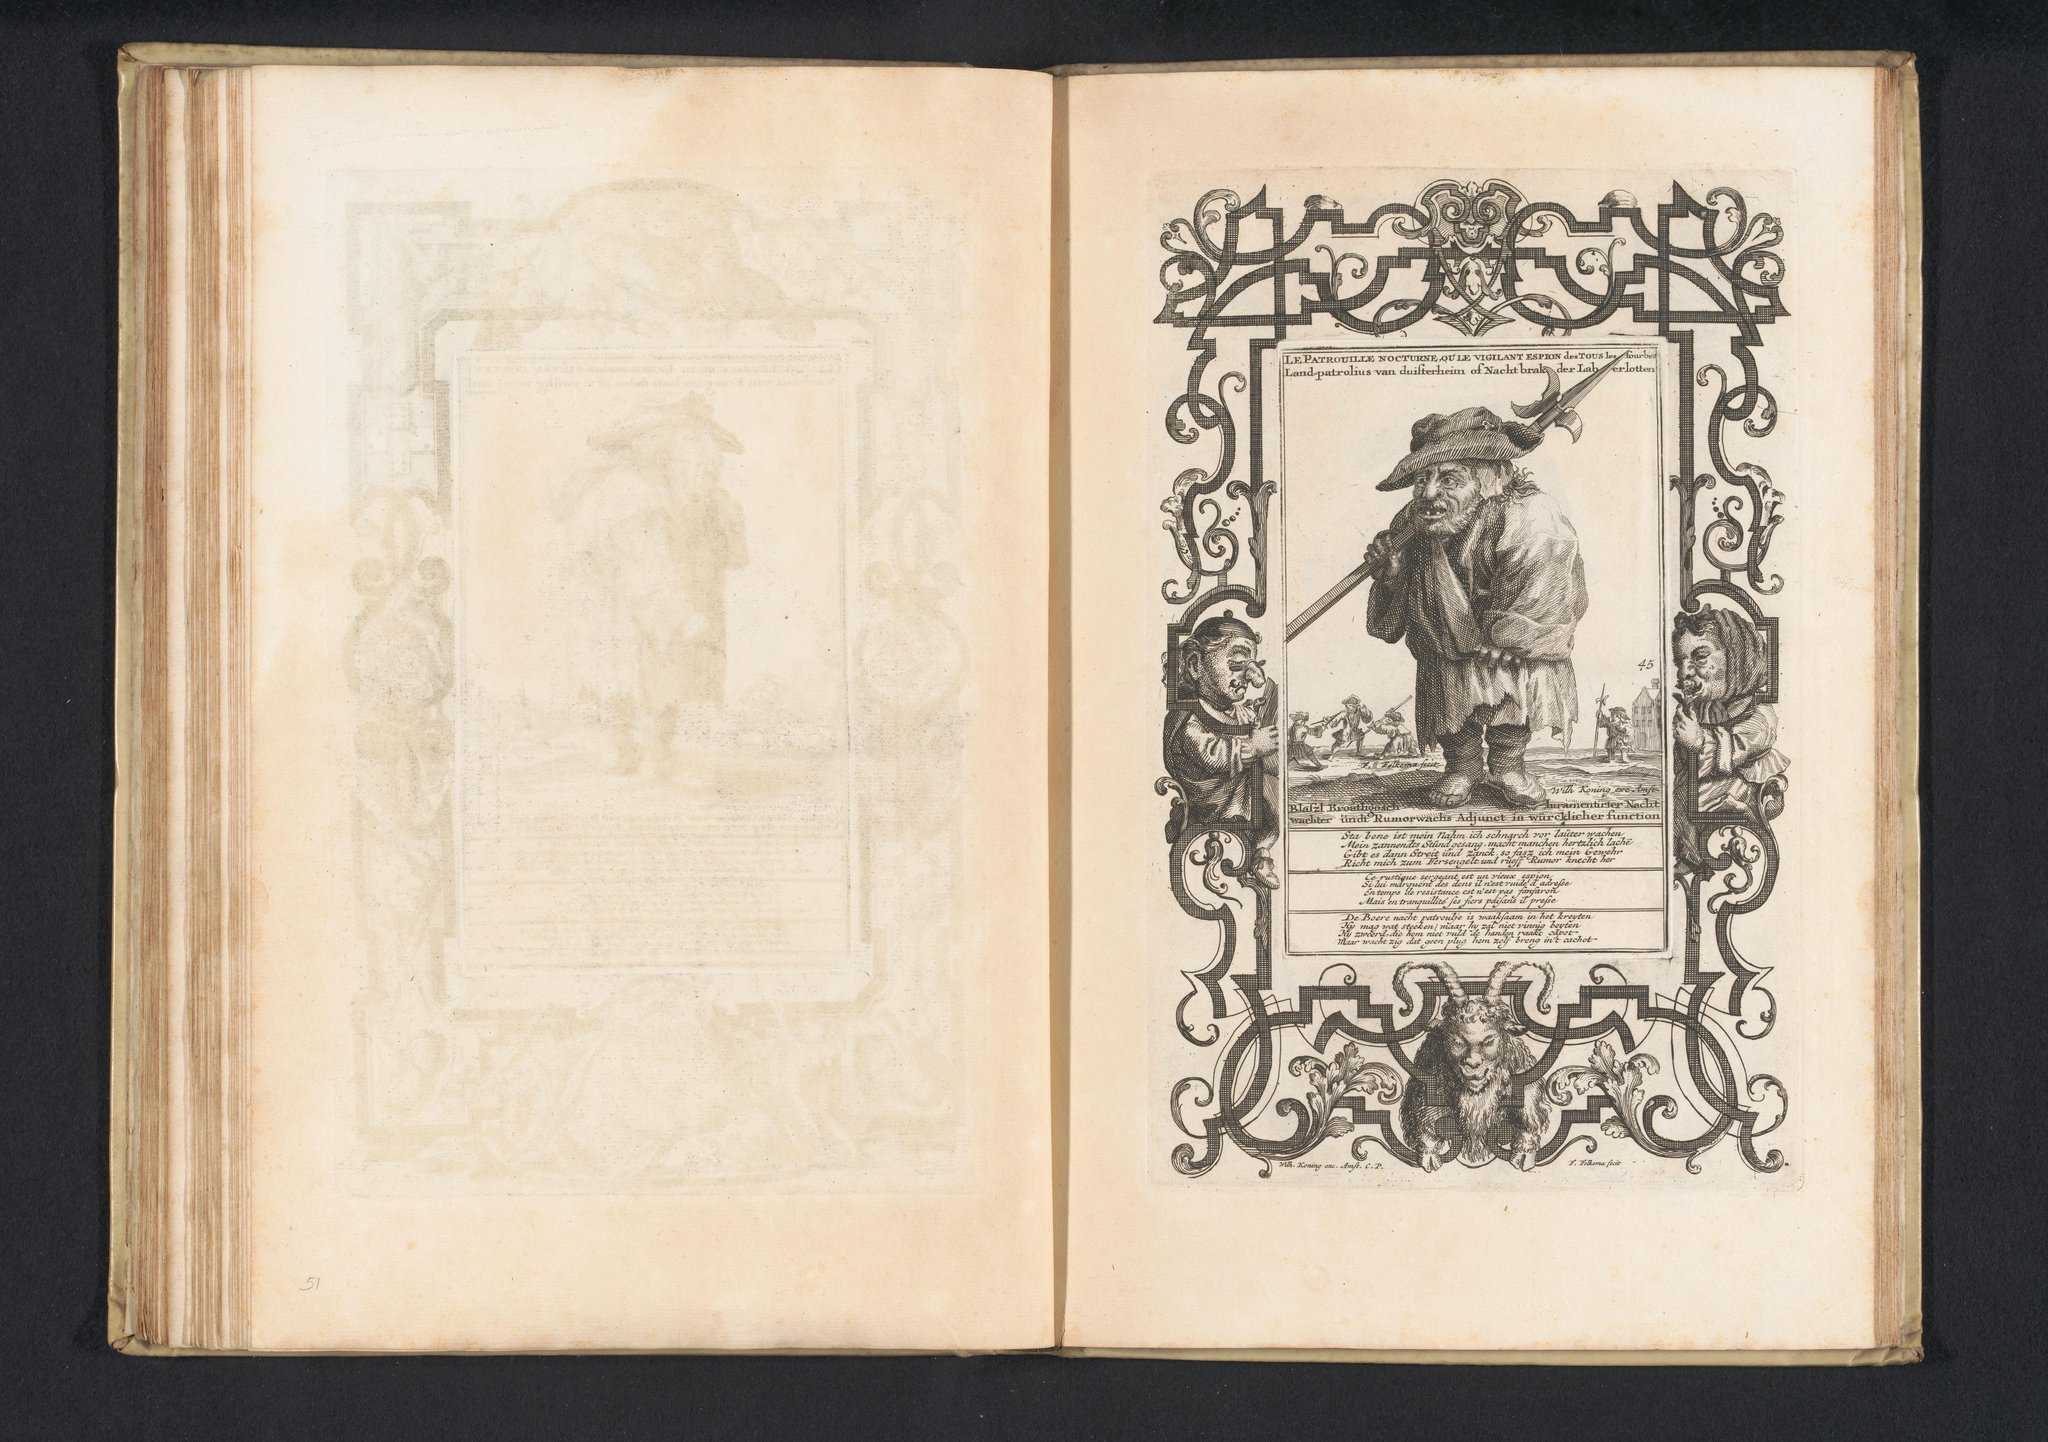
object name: print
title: De kleine mens Land-patrolius van duisterheim, 1720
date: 1716-1720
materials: paper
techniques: etching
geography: amsterdam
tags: night patrol, caricatures (human types), little people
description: De kleine mens Land-patrolius van duisterheim als nachtwaker. In het onderschrift verzen in het Duits, Frans en Nederlands. Genummerd rechts midden: 45. Afdruk binnen een decoratieve omlijsting gedrukt van een aparte plaat met kleine mensen en onderaan een bok. Onderdeel van deel II in de tweede Nederlandse gebonden uitgave uit 1720 (en gerelateerd aan de Windhandel in dat jaar) van een serie karikaturen van kleine mensen, bekend als Het Dwergentooneel, deels gekopieerd naar een ouder Duits voorbeeld.